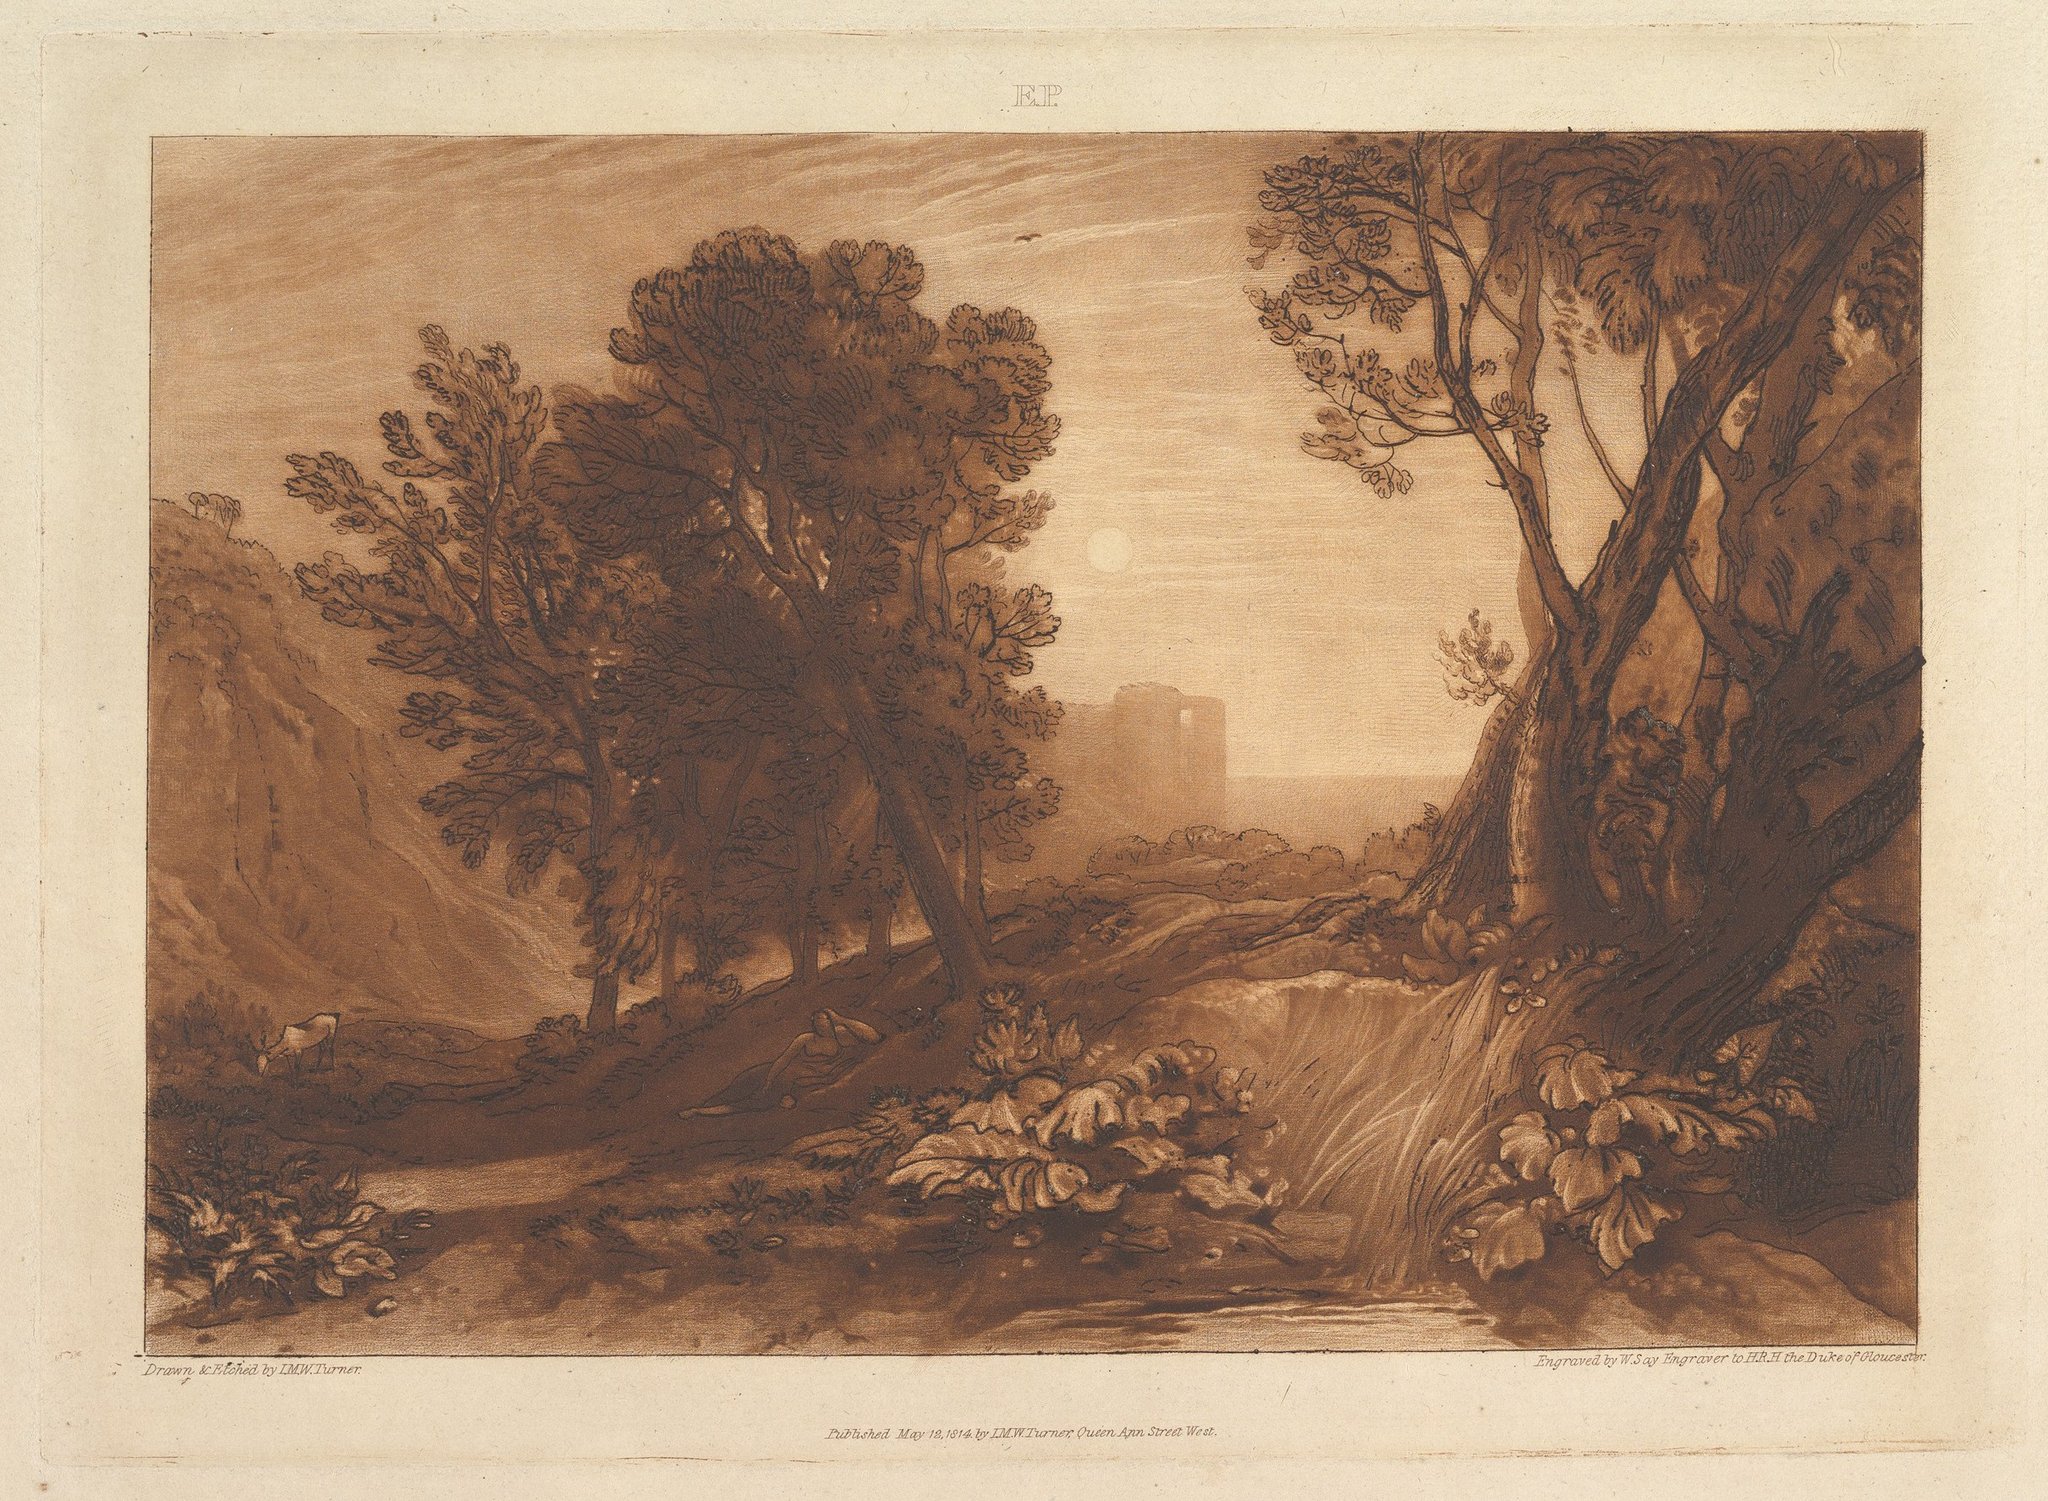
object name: print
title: Solitude, or The Reading Magdalen, part XI, plate 53 from "Liber Studiorum"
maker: joseph mallord william turner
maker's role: artist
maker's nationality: british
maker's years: 1775-1851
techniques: etching, mezzotint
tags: sun,landscapes,trees